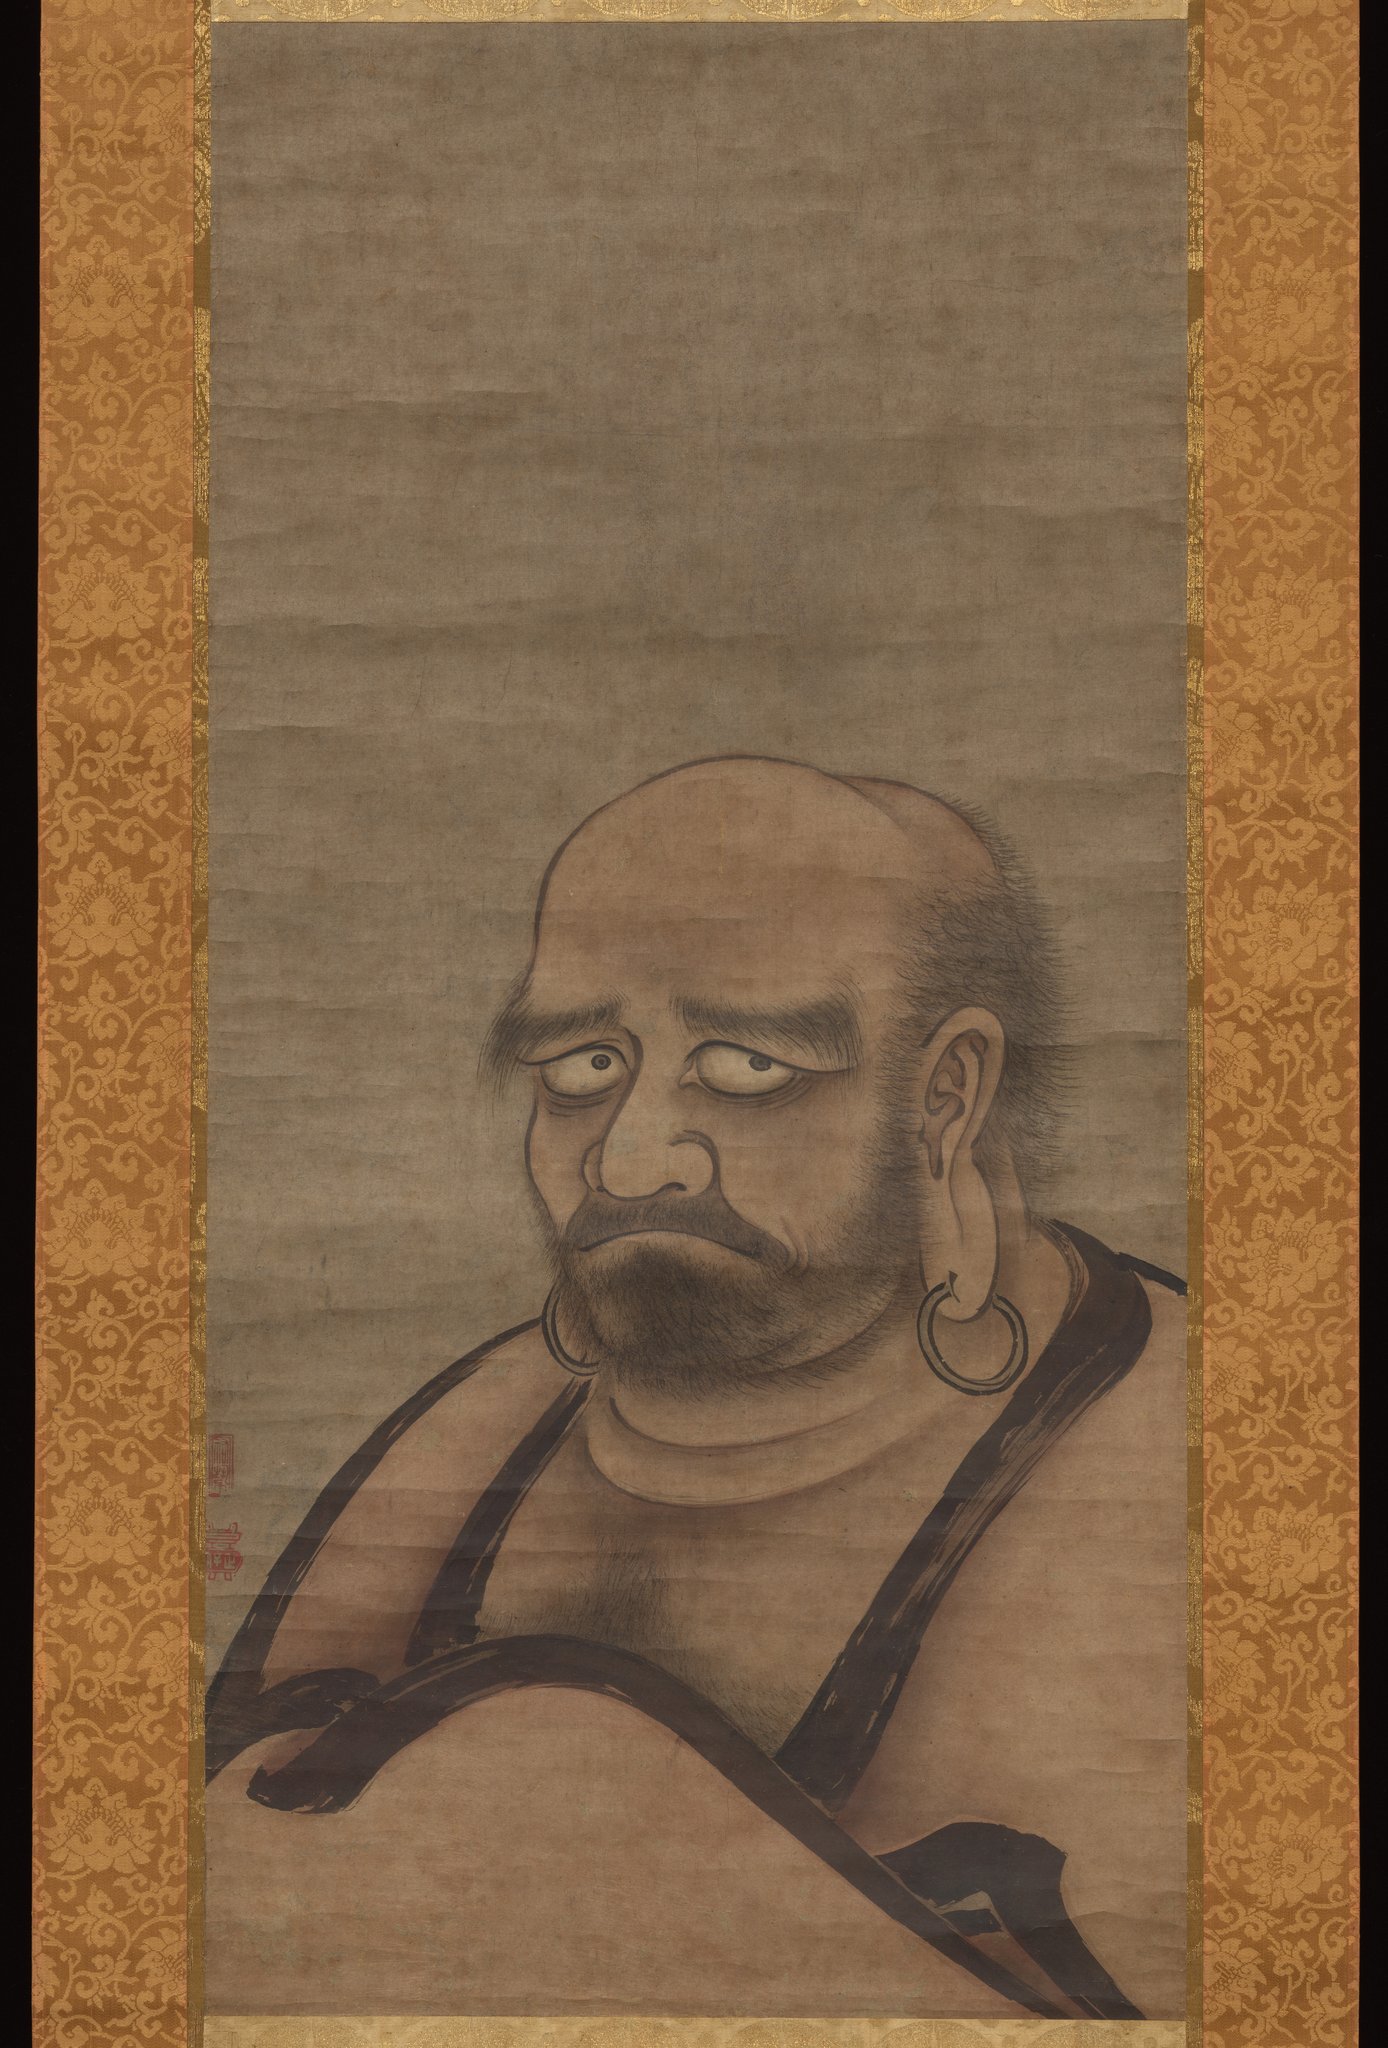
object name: hanging scroll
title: Bodhidharma in Red Robes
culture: japanese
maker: kano masanobu 狩野正信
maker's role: artist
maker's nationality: japanese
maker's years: 1434-1530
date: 1467-1500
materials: ink, paper